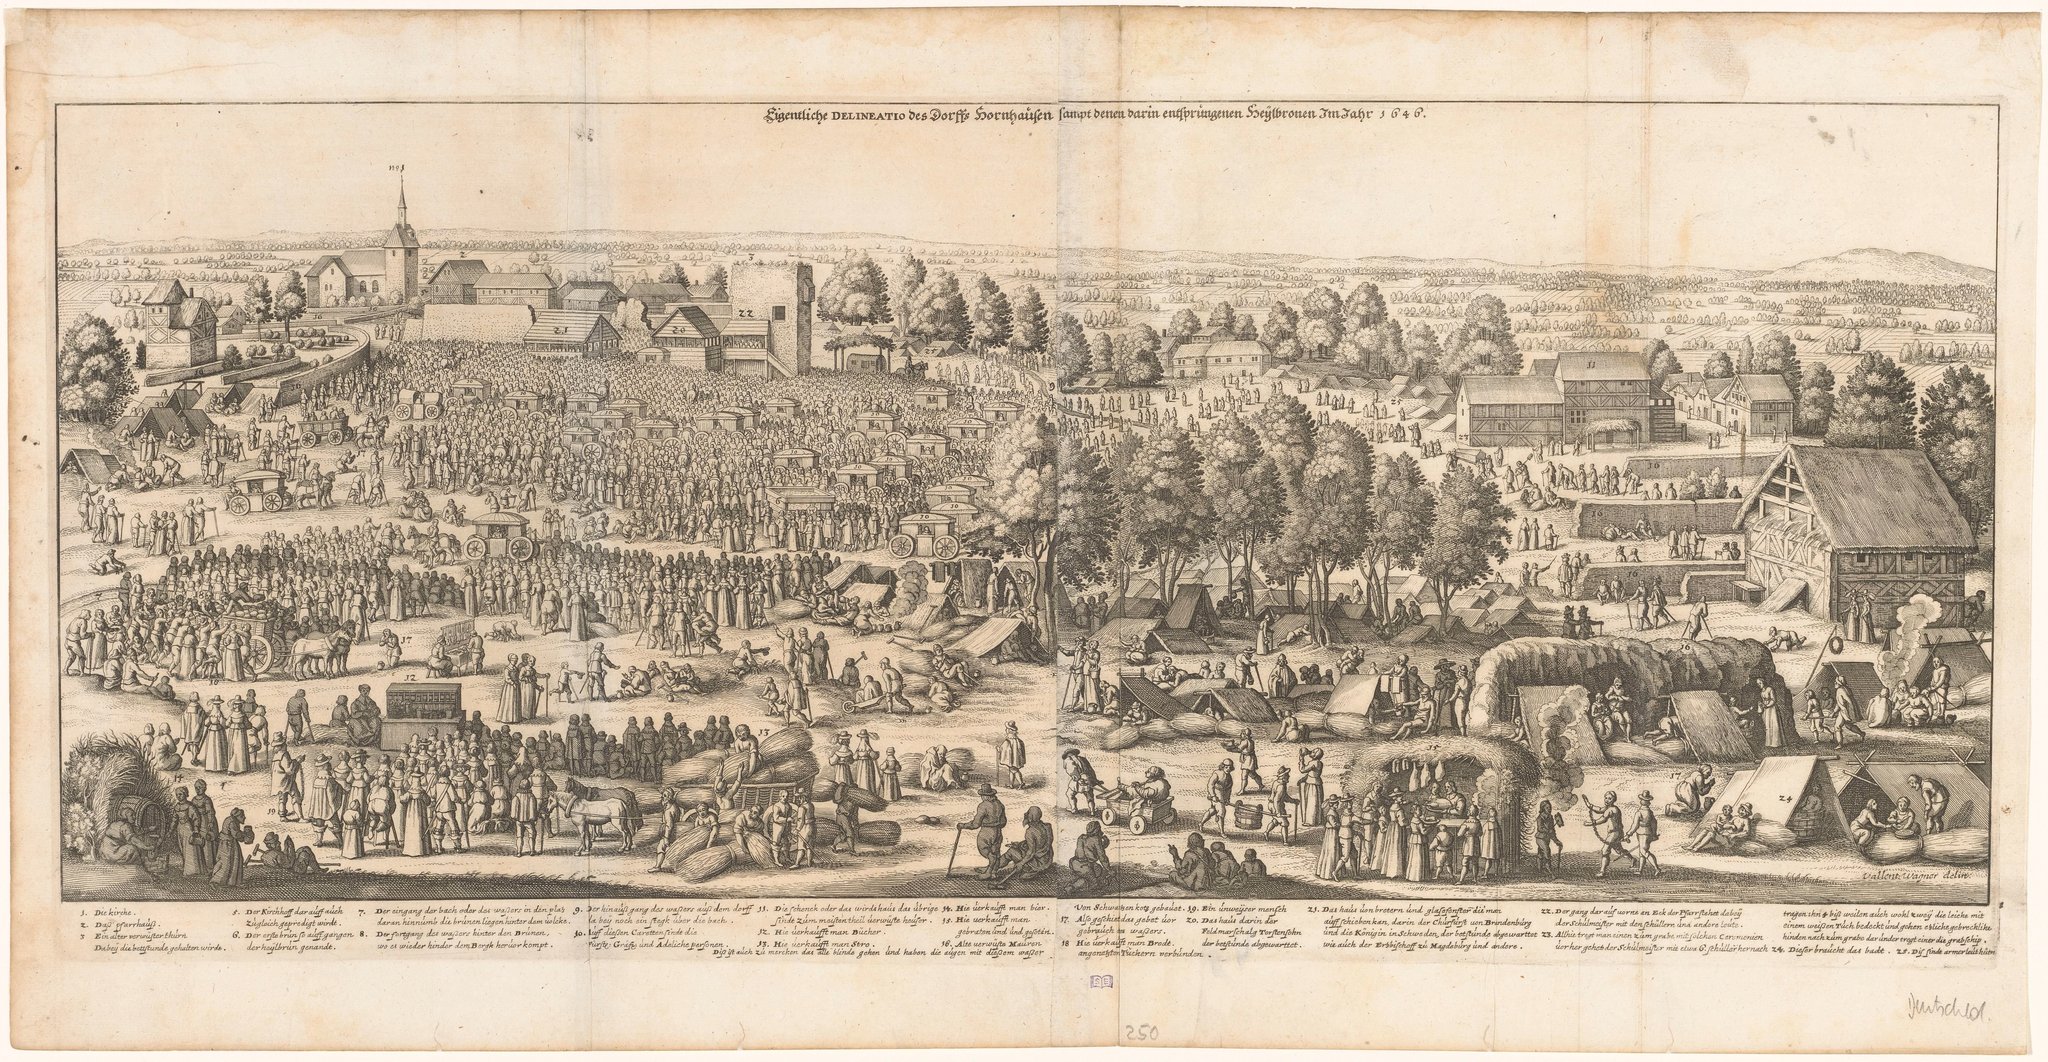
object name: book illustration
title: Eigentliche Delineatio des Dorffs Hornhausen sampt denen darin entspringenen Heylbronen im Jahr 1646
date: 1647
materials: paper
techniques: etching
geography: dresden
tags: book-stall, kiosk, street-trader, watering-place, spa, tent-camp, city-view in general; 'veduta' (+ city(-scape) with figures, staffage)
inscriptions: collector's mark: Lugt 4780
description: Gezicht op het dorp Hornhausen waar een menigte zich heeft verzameld rond de heilzame bronnen op het dorpsplein. Op de voorgrond badende mensen en verschillende handelaren waaronder verkopers van vlees, brood en bier. Geheel links een vrouwelijke boekverkoper naast een boekenkraam. Met legenda onder de afbeelding waarin 25 verschillende scènes worden geïdentificeerd.